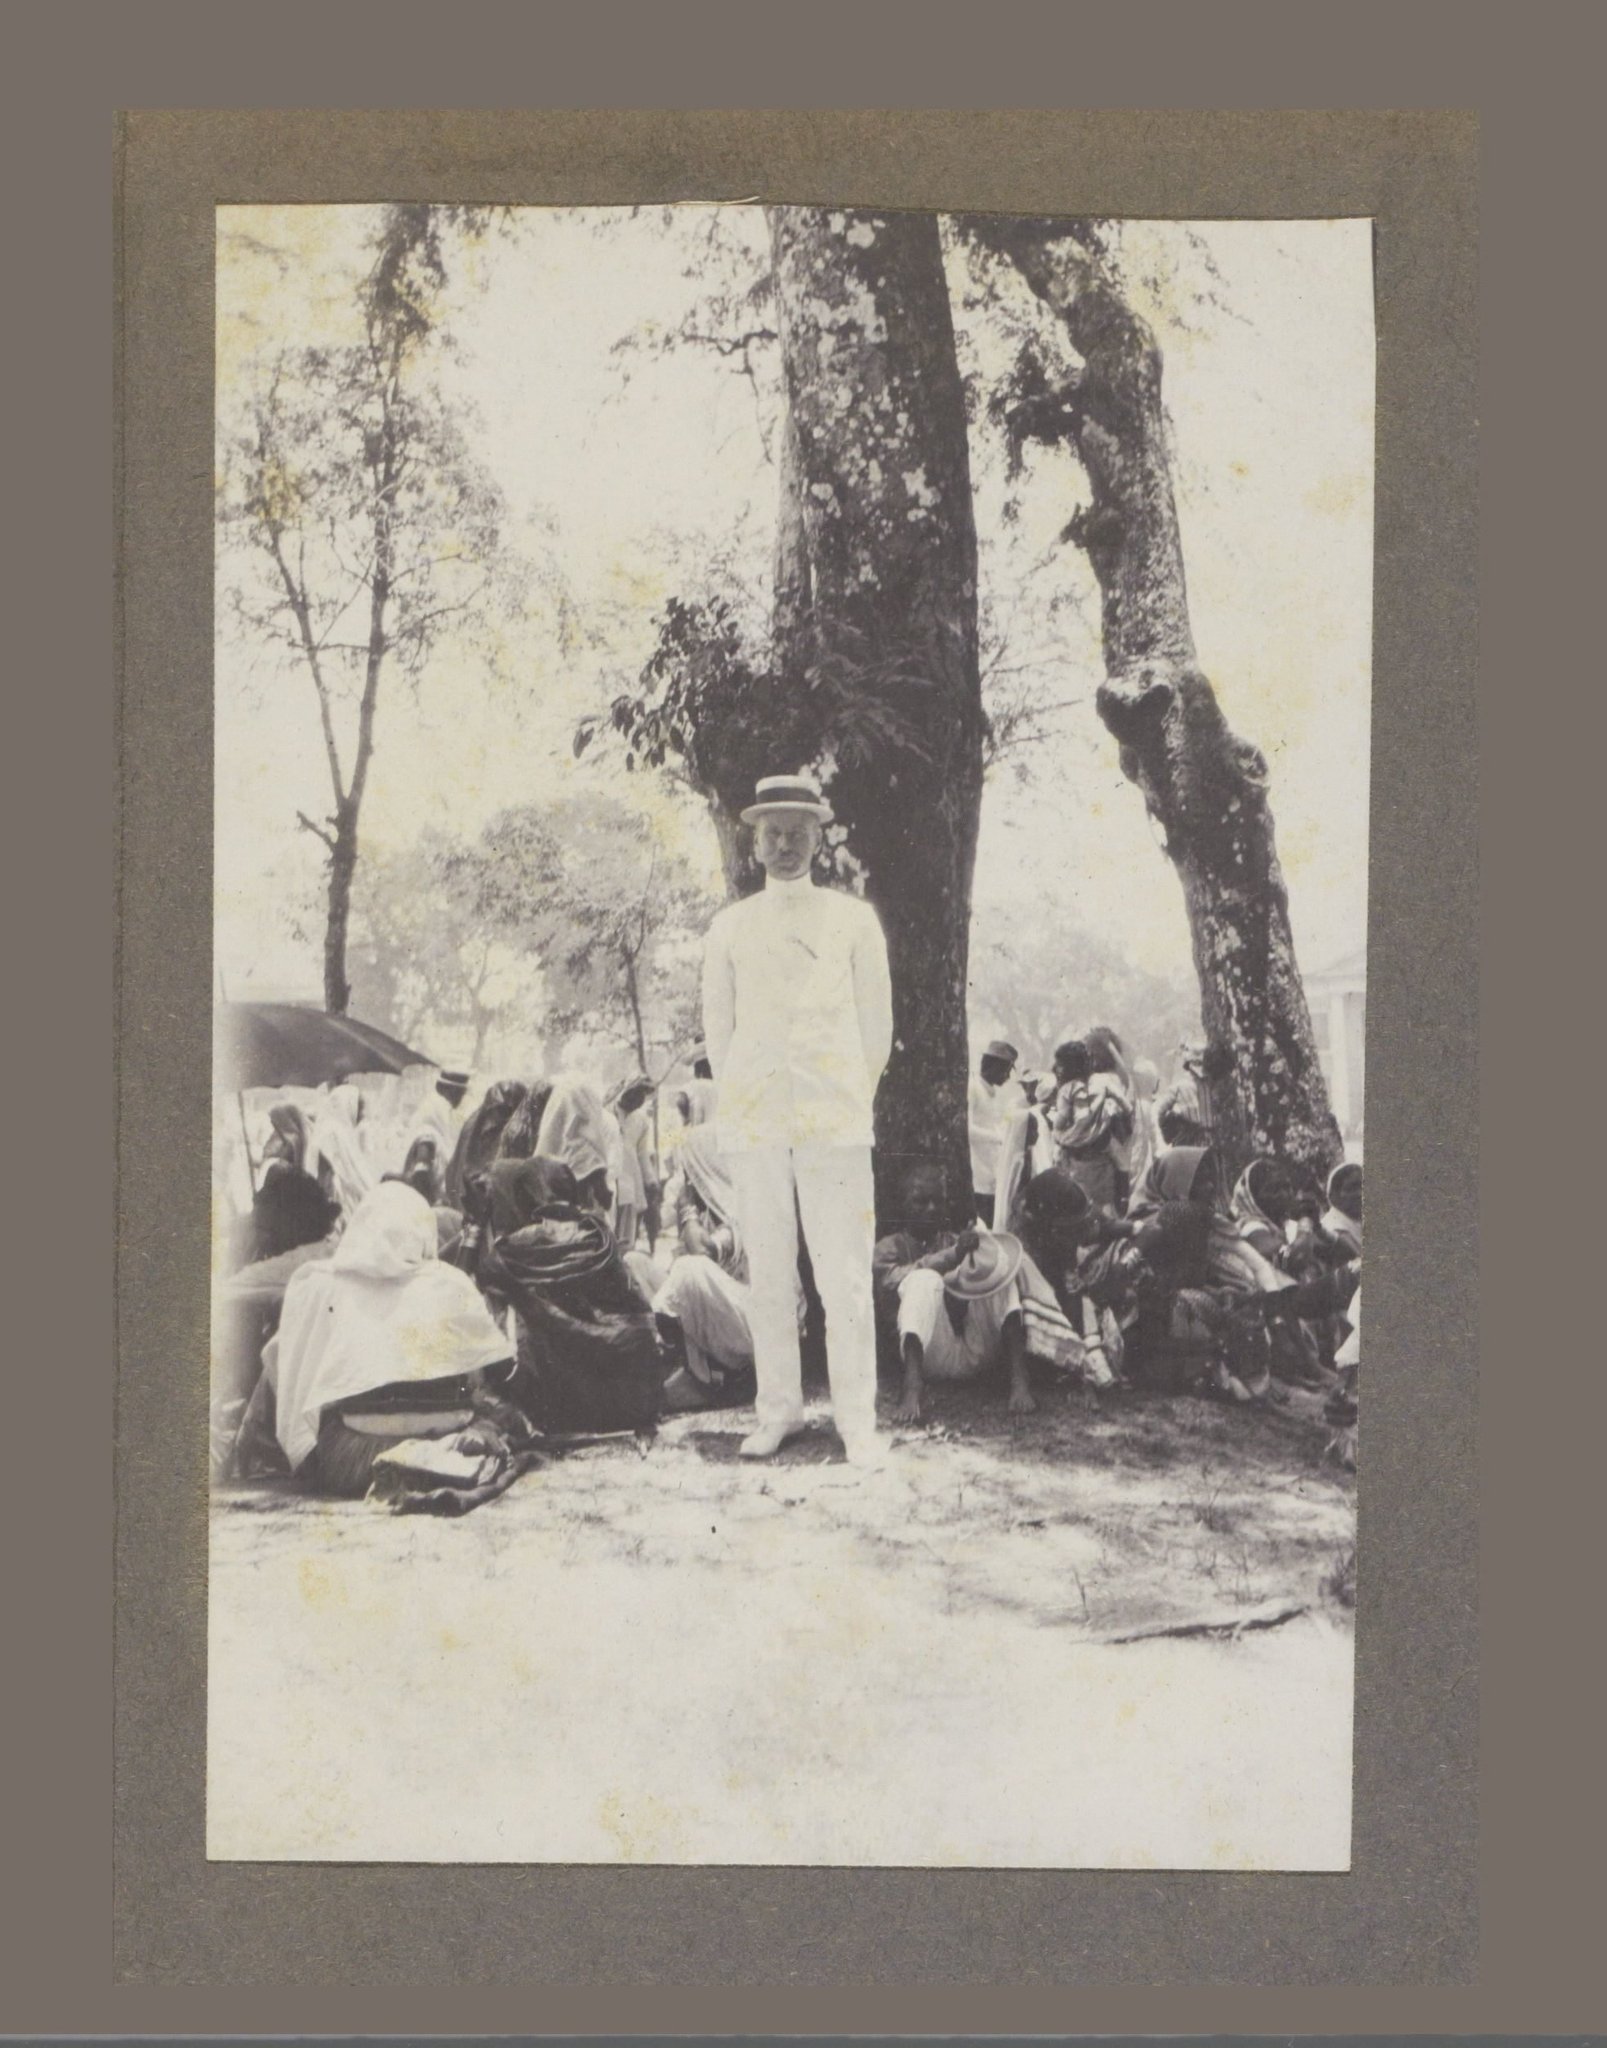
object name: photograph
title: Andries Boom, met een groep zittende Hindostanen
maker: Anonymous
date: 1912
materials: photographic support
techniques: photography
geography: suriname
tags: andries augustus boom, working class, labourers, suriname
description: Andries Boom staande tussen een groep zittende contractarbeiders uit Brits-Indië. Onderdeel van het fotoalbum over het leven van de familie Gonggrijp in Suriname rond 1912.